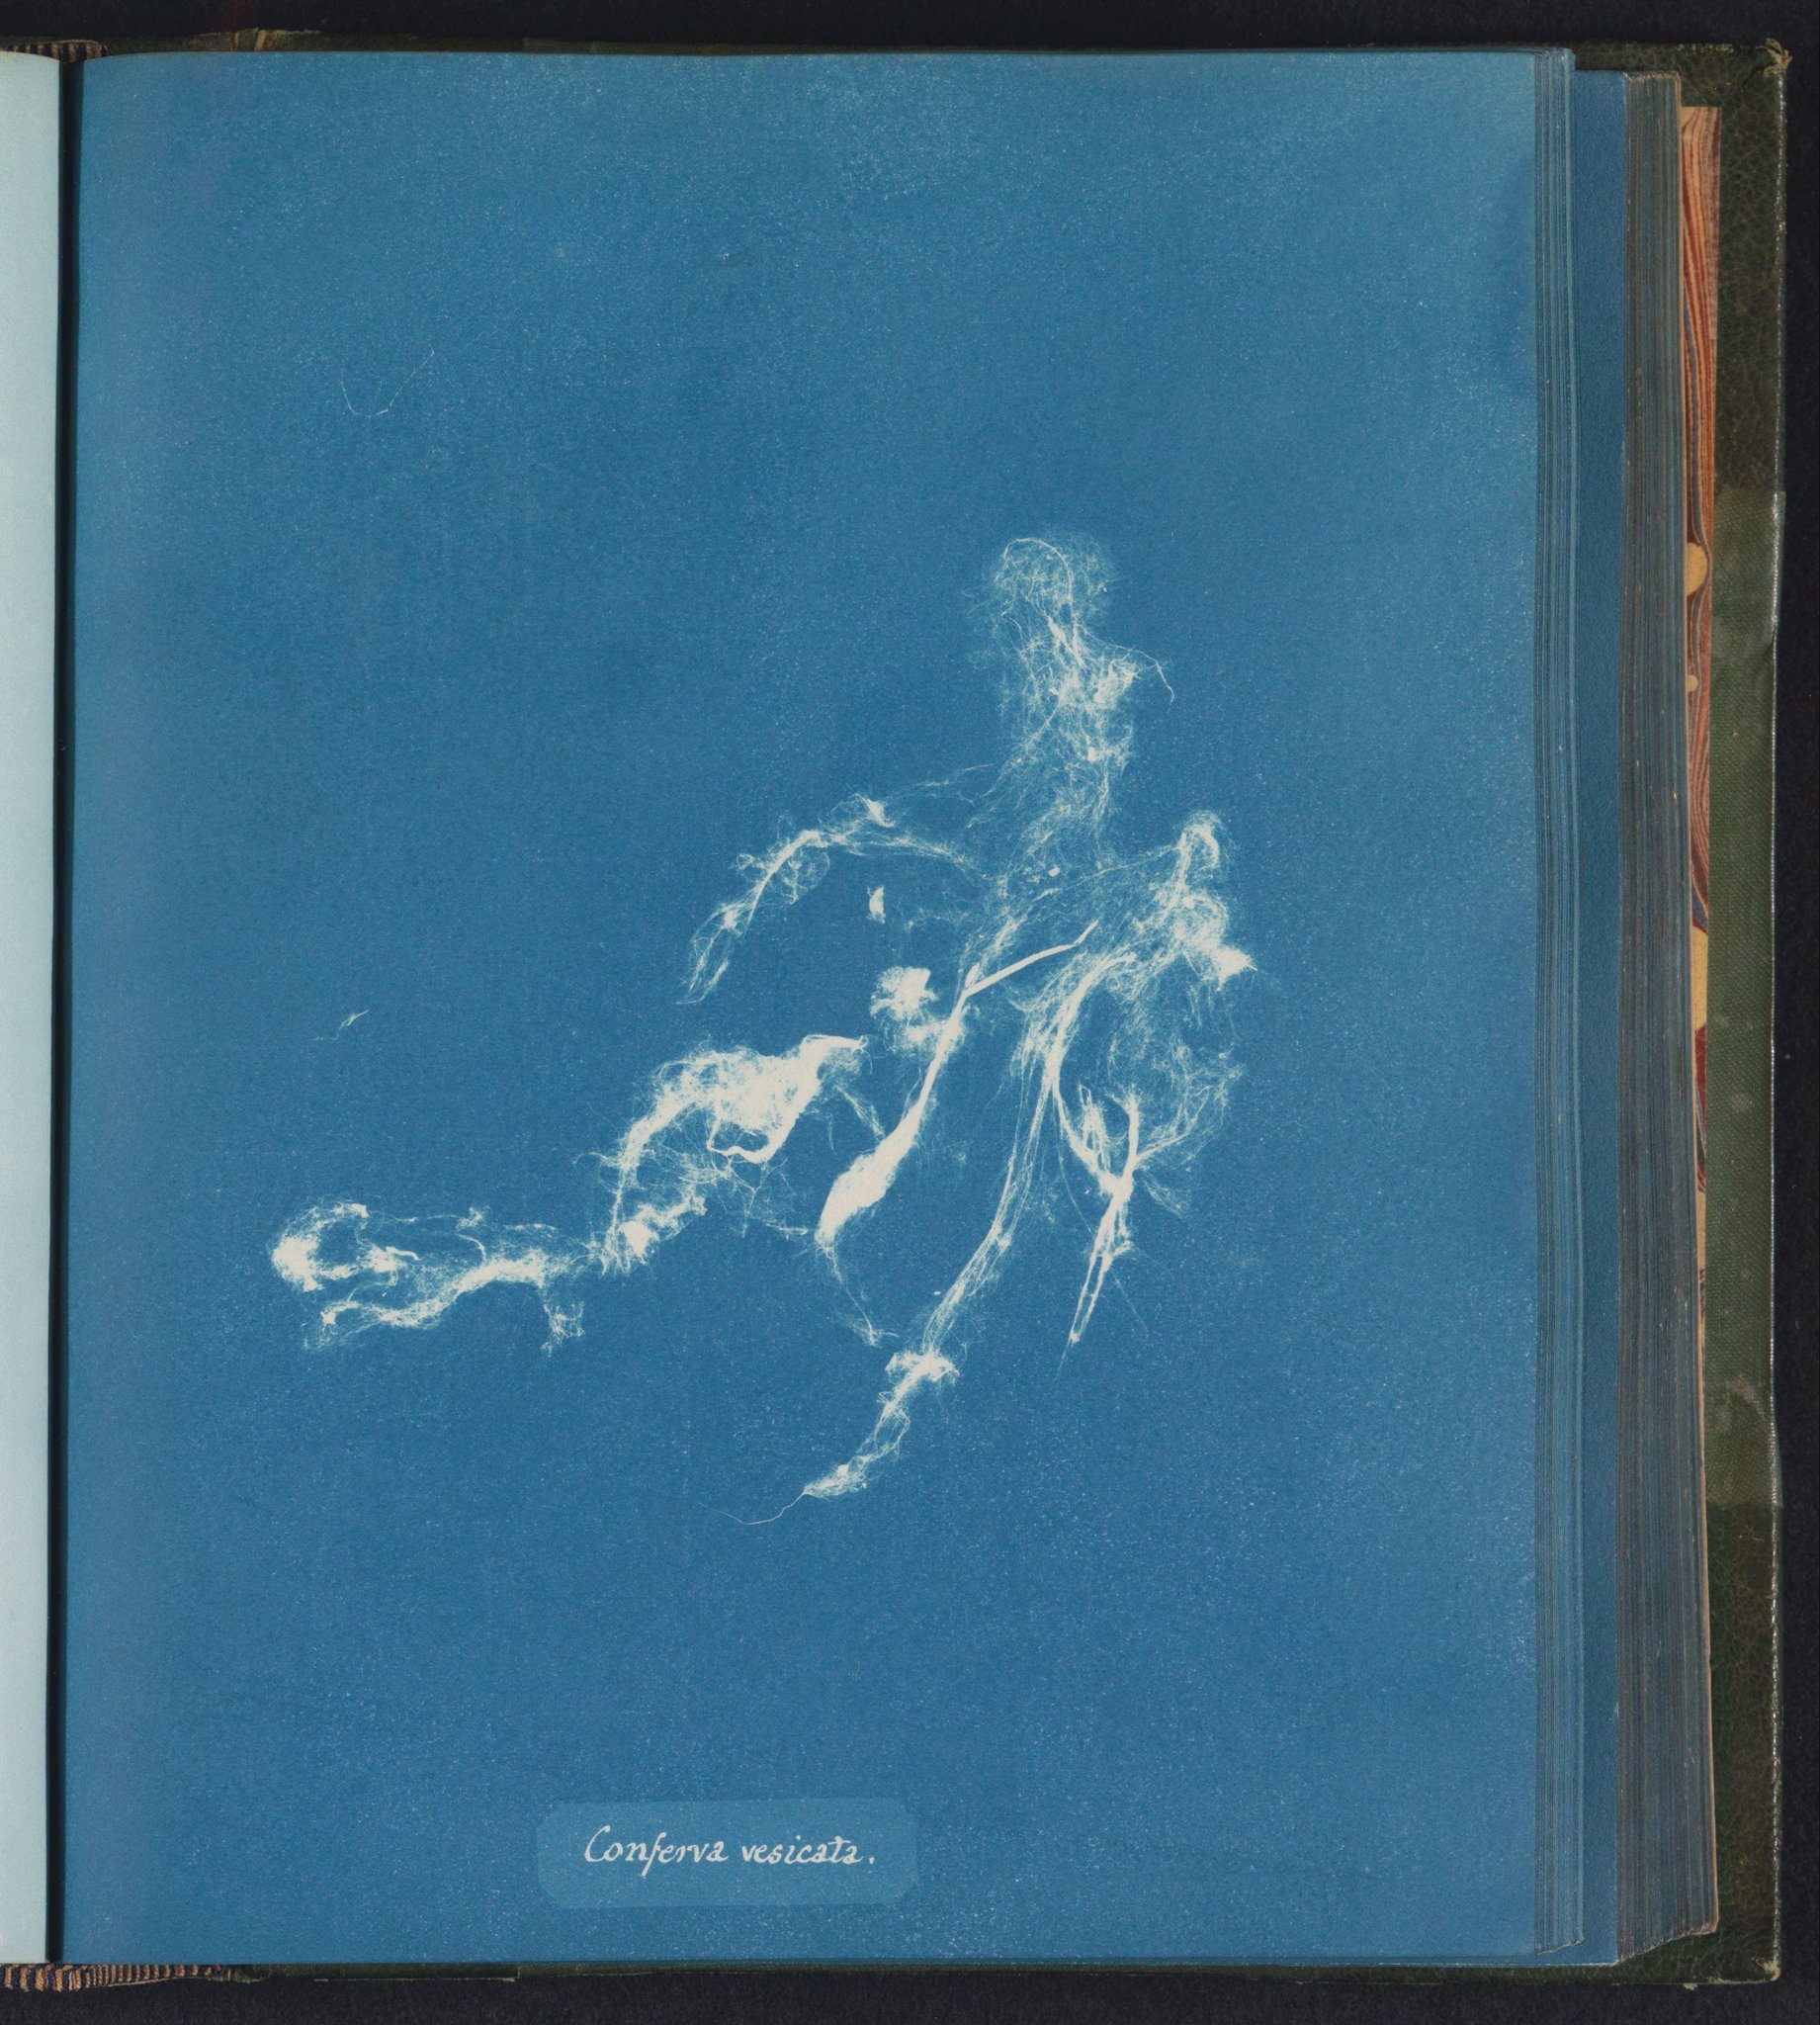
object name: page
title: Zeewier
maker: anna atkins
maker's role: fotograaf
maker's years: 1799-1871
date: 1843-1853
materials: photographic support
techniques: cyanotype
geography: united kingdom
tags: algae, seaweed